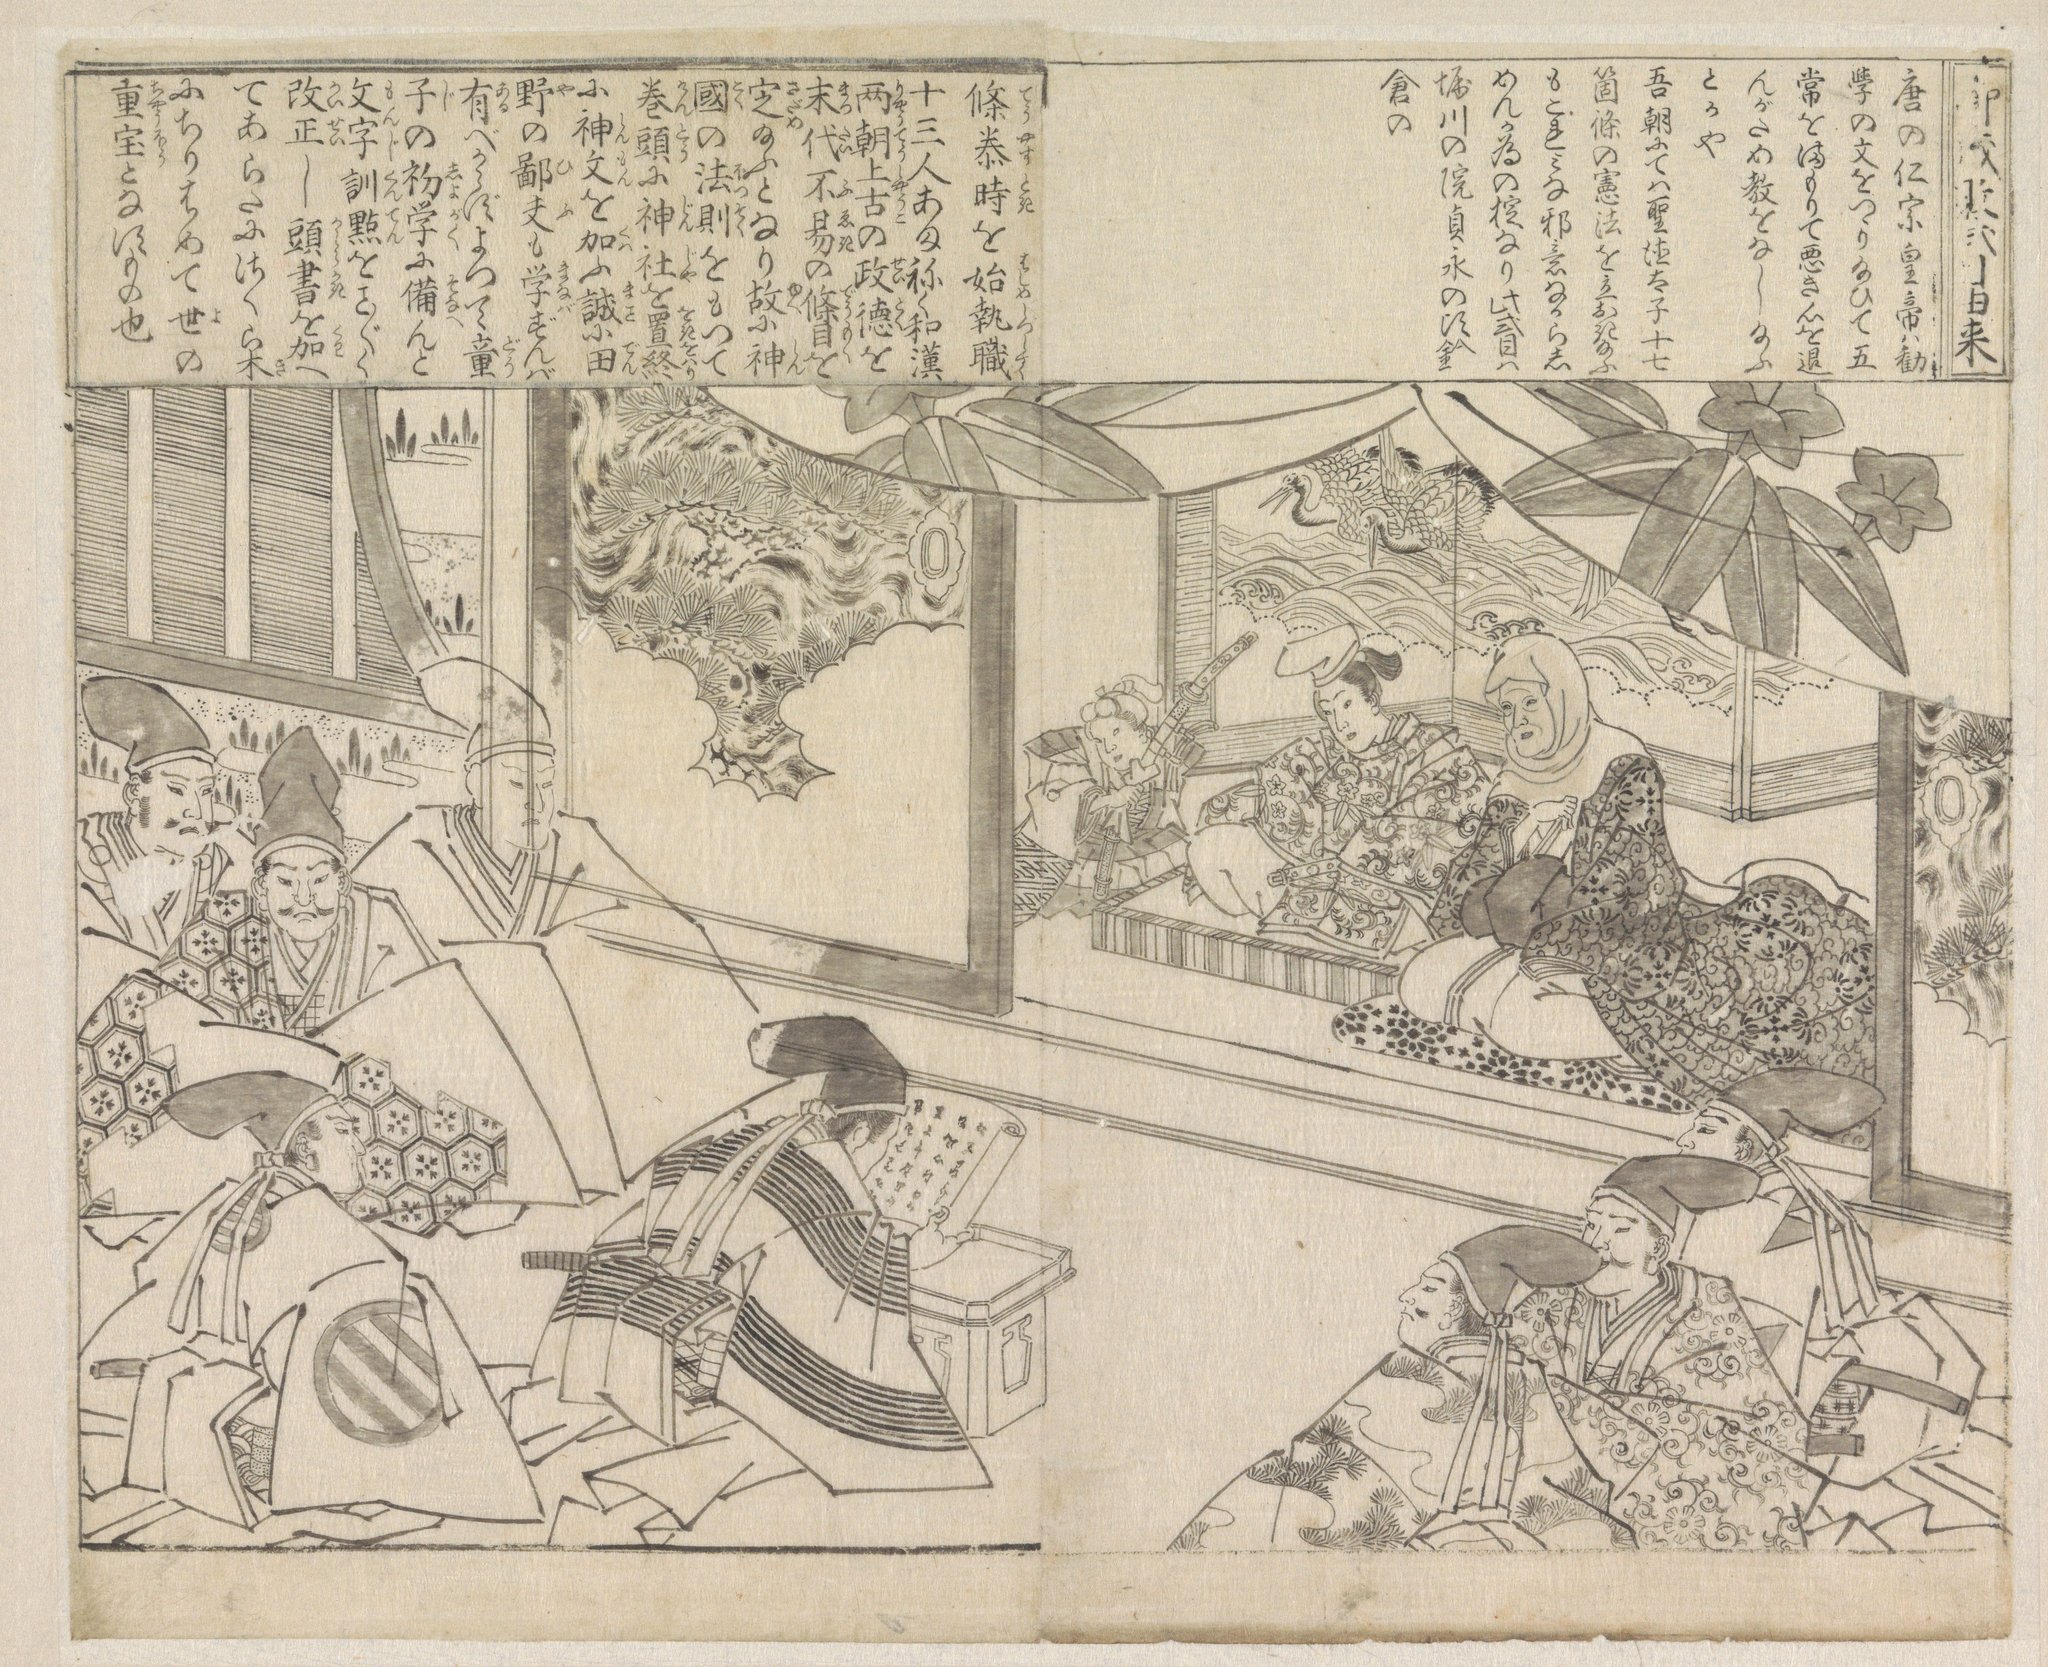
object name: drawing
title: Jonge prins onvangt lezende man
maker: Anonymous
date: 1700-1900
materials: ink, paper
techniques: brush, pen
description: Jongeman gezeten op verhoging naast een oudere vrouw, onvangt een groep hooggeplaatste mannen, waarvan een uit een handrol voorleest.